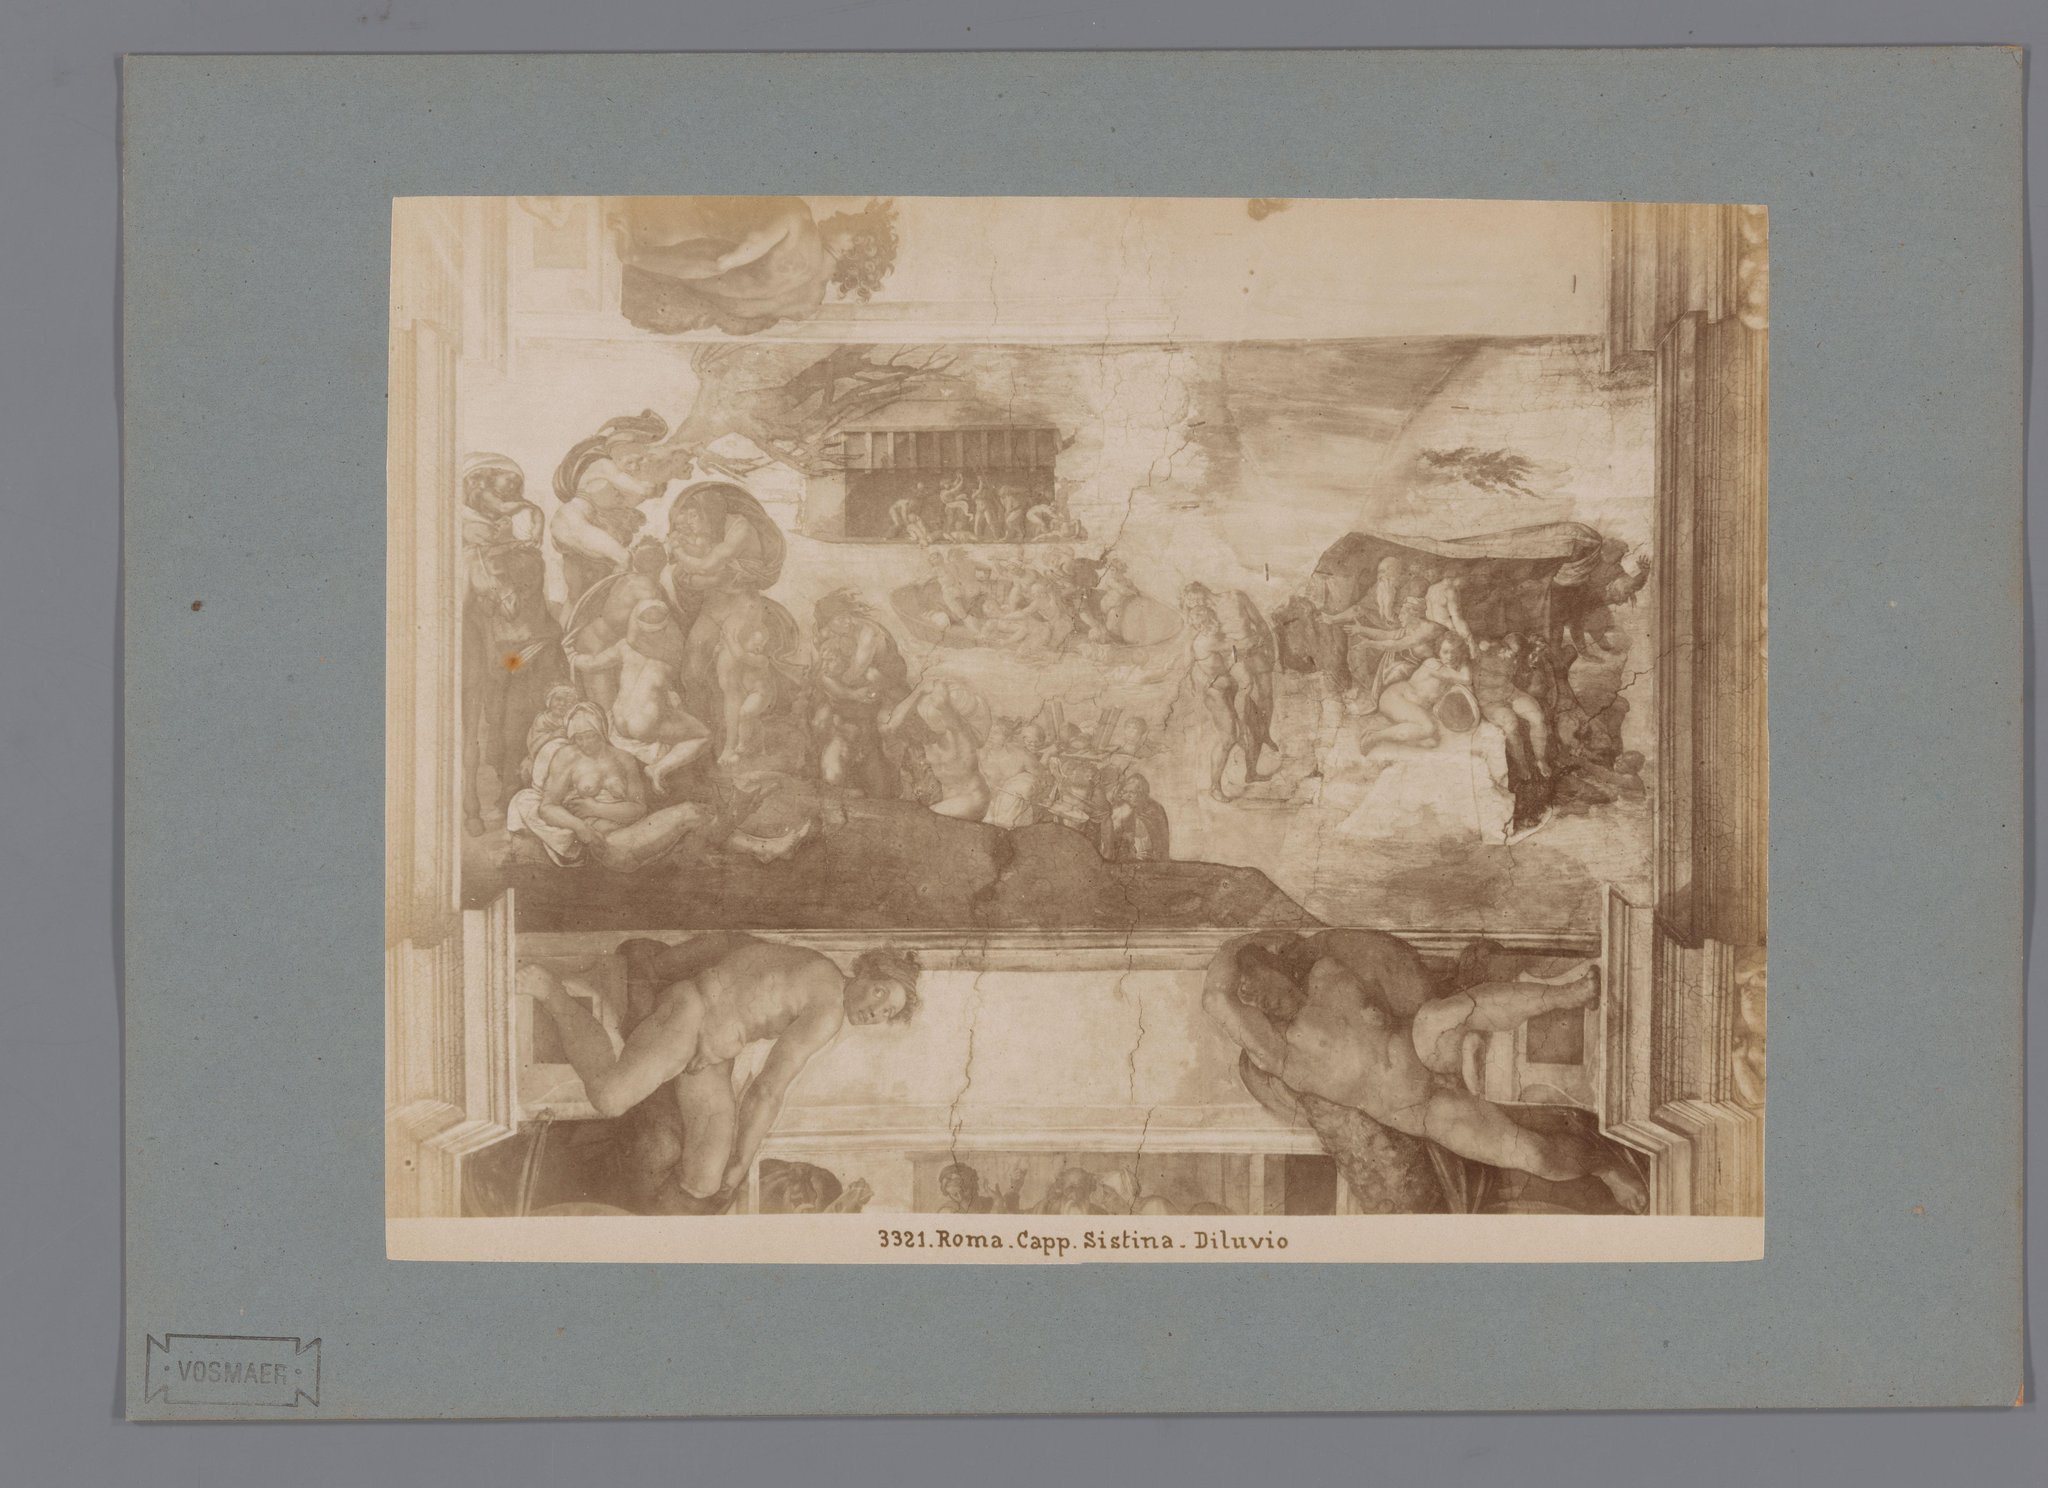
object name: reproduction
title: Fotoreproductie van het fresco De zondvloed door Michelangelo in de Sixtijnse kapel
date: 1851-1900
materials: cardboard, paper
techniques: albumen print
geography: vatican city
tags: the flood and destruction of mankind ~ story of noah (genesis 7:10 - 8:17), picture, painting, wall-covering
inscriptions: collector's mark: ‘VOSMAER’, number: ‘3321.’